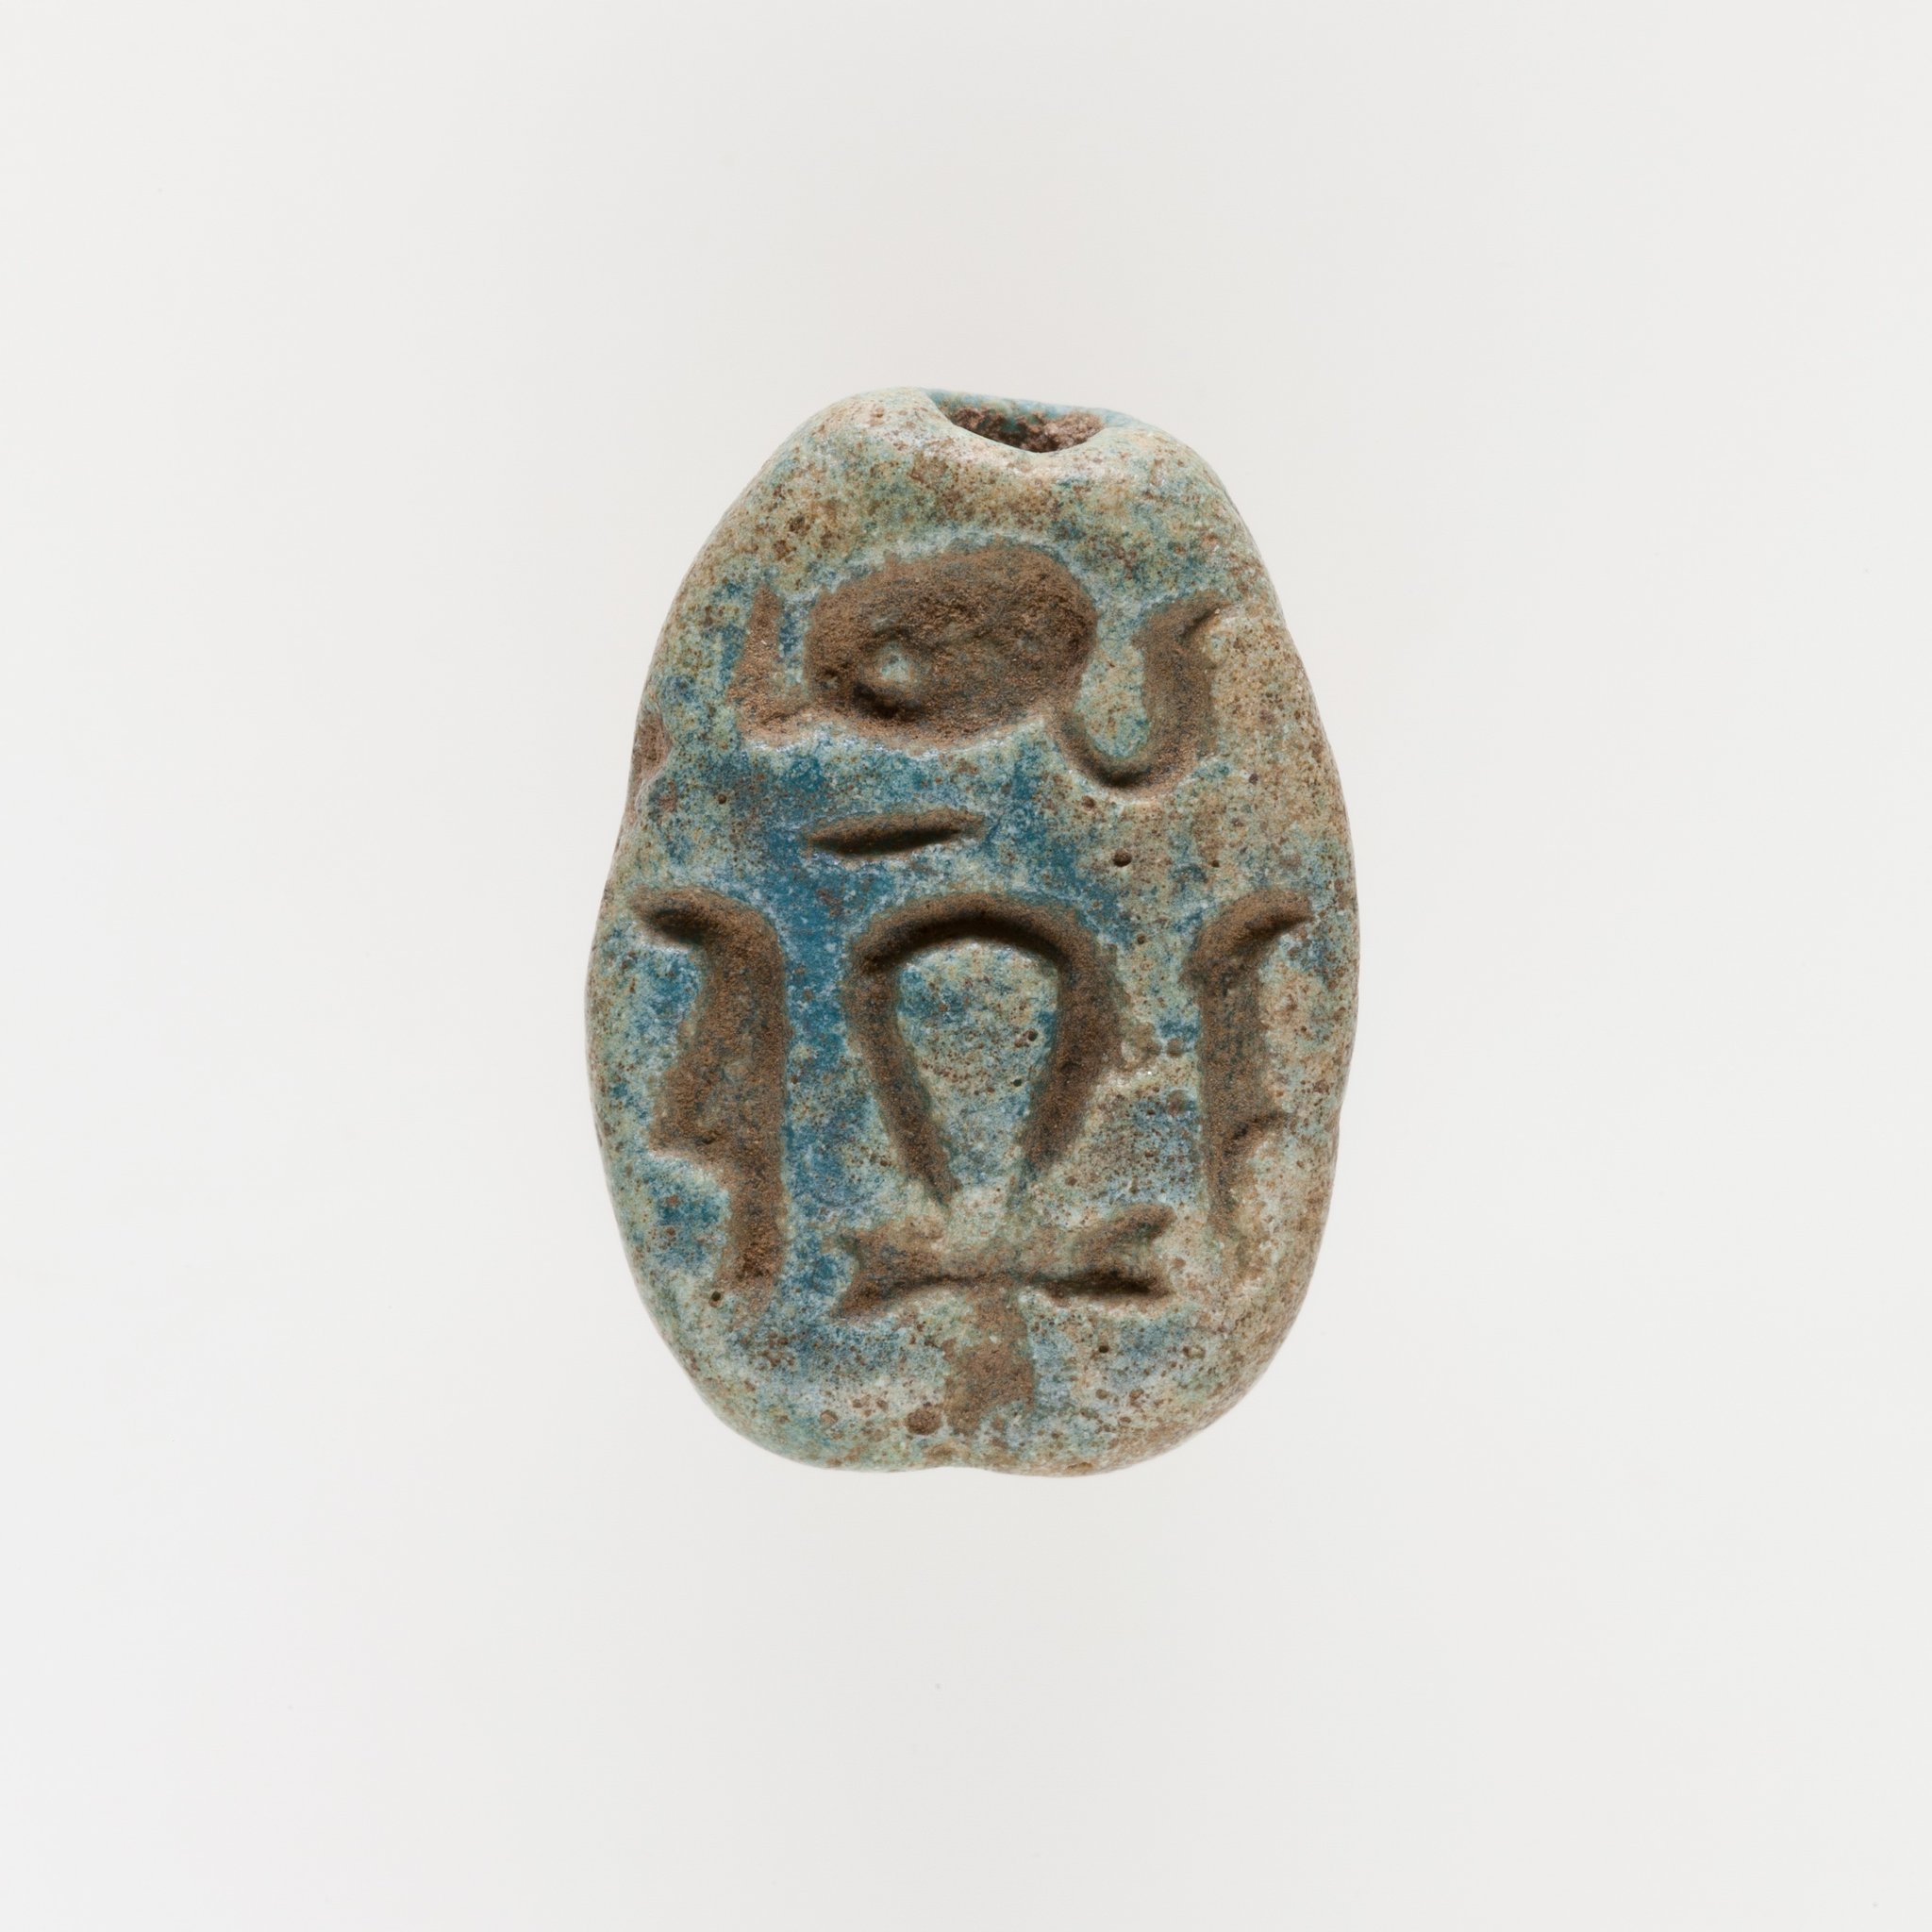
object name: scarab, sun disk with uraei, hieroglyph, ankh, ostrich feather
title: Scarab Inscribed with Hieroglyphs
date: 1295-1070 BCE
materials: faience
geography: egypt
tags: hieroglyphs,scarabs